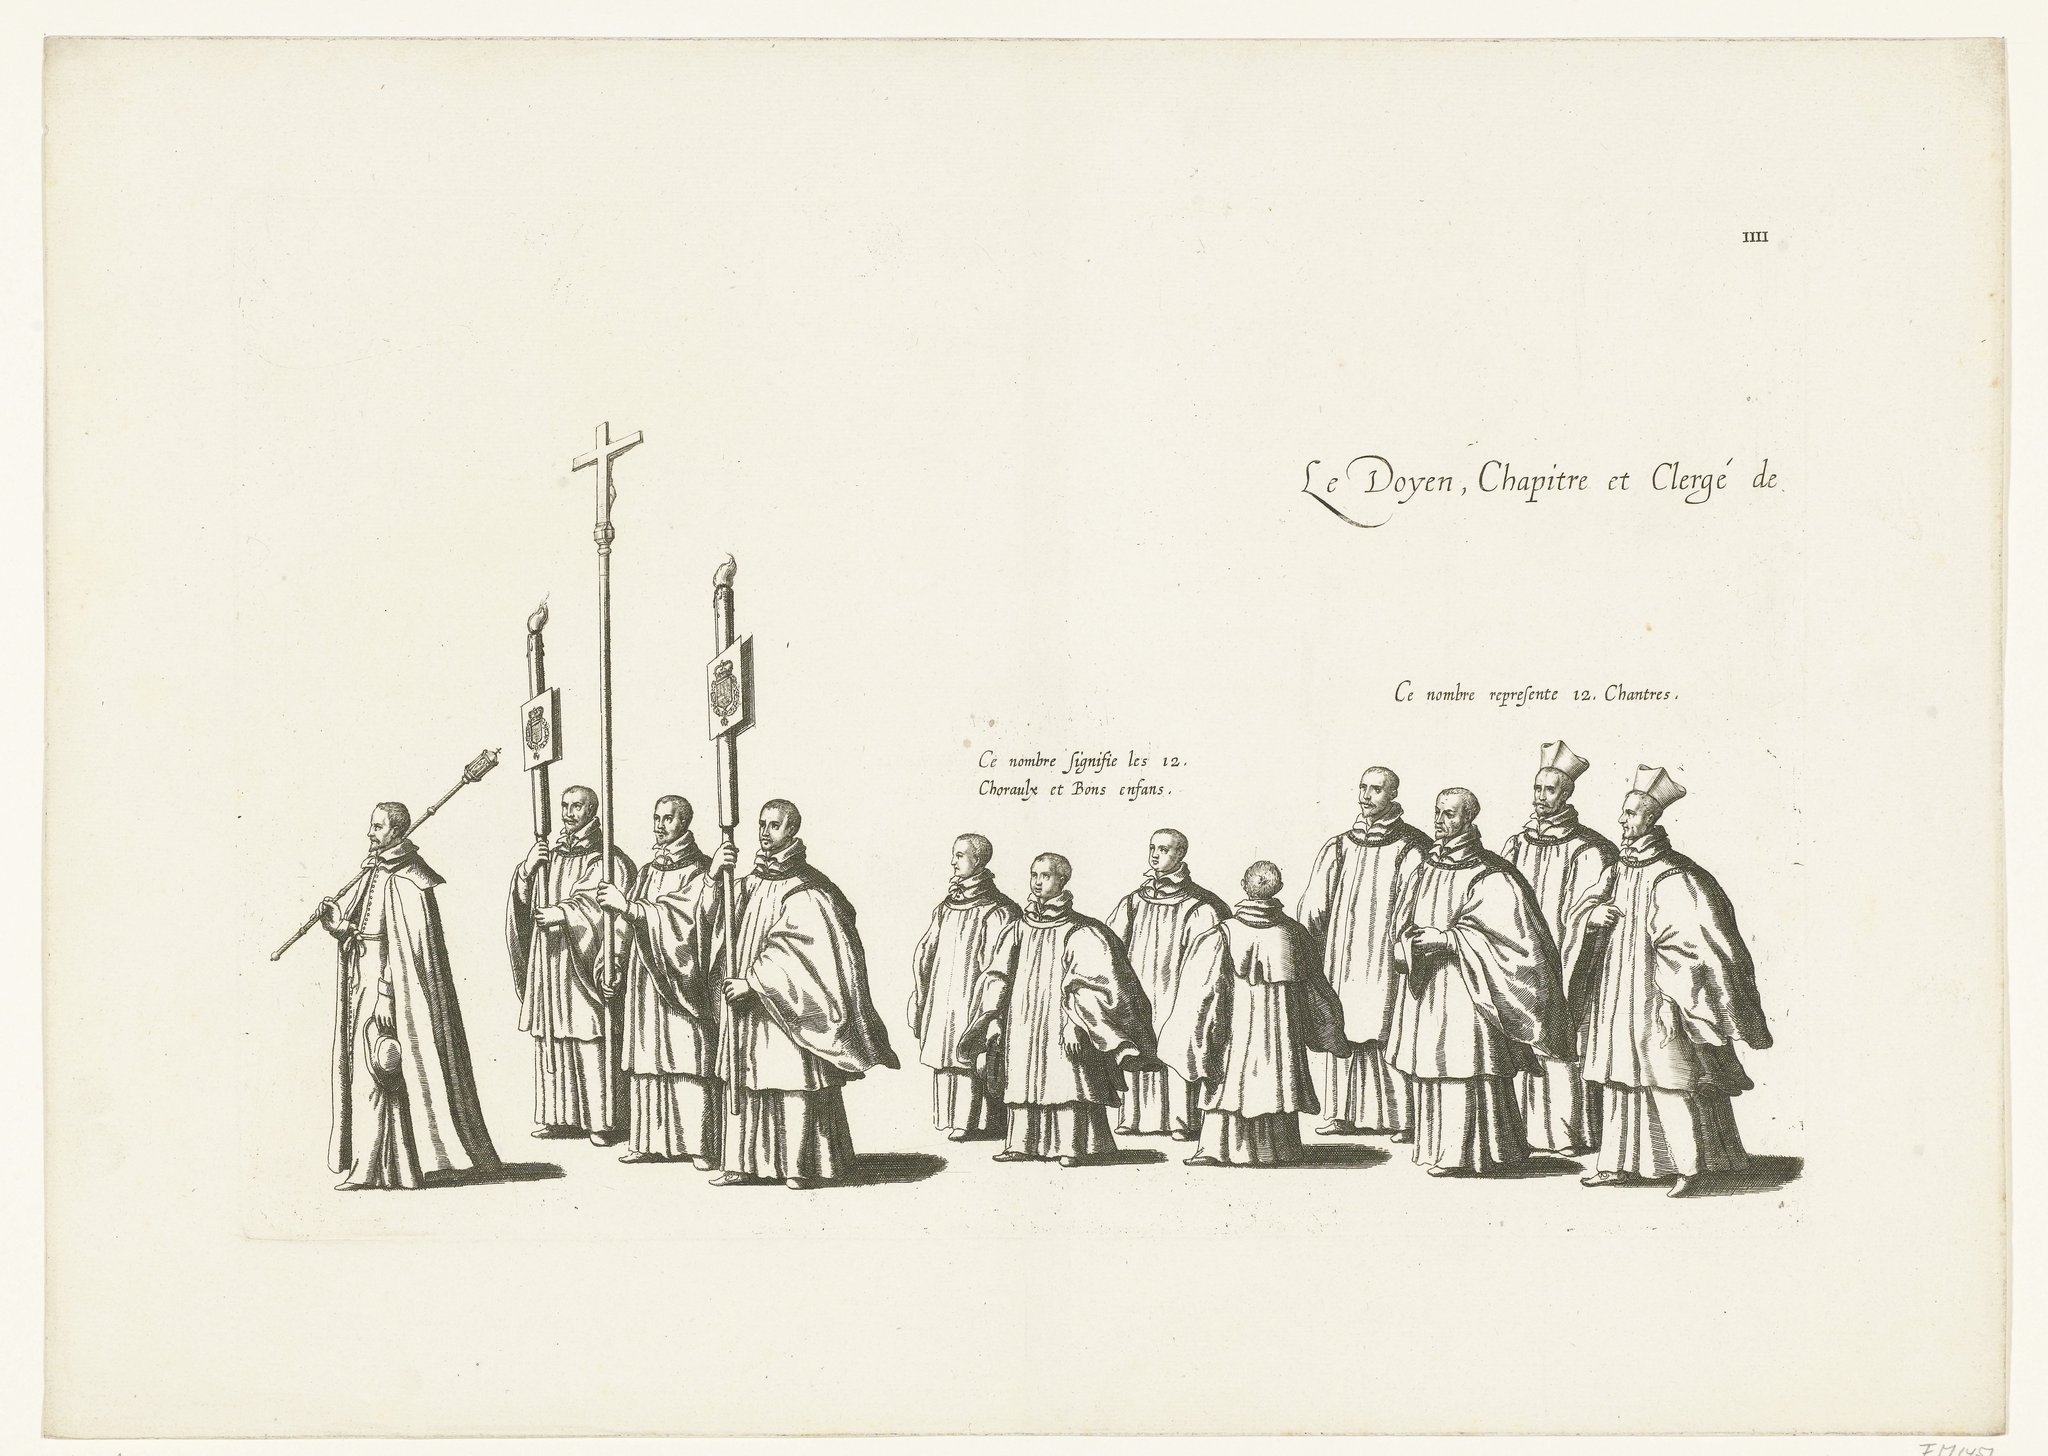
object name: print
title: Pompa funebris optimi potentissimiq. principis Alberti pii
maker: cornelis galle (i)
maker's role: print maker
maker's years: 1576-1650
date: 1623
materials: paper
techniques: etching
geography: southern netherlands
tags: brussels, albrecht aartshertog van oostenrijk, cortege, funeral procession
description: Deelnemers aan de begrafenisstoet. Plaat IIII in de serie van de begrafenis van aartshertog Albrecht van Oostenrijk te Brussel op 12 maart 1622.